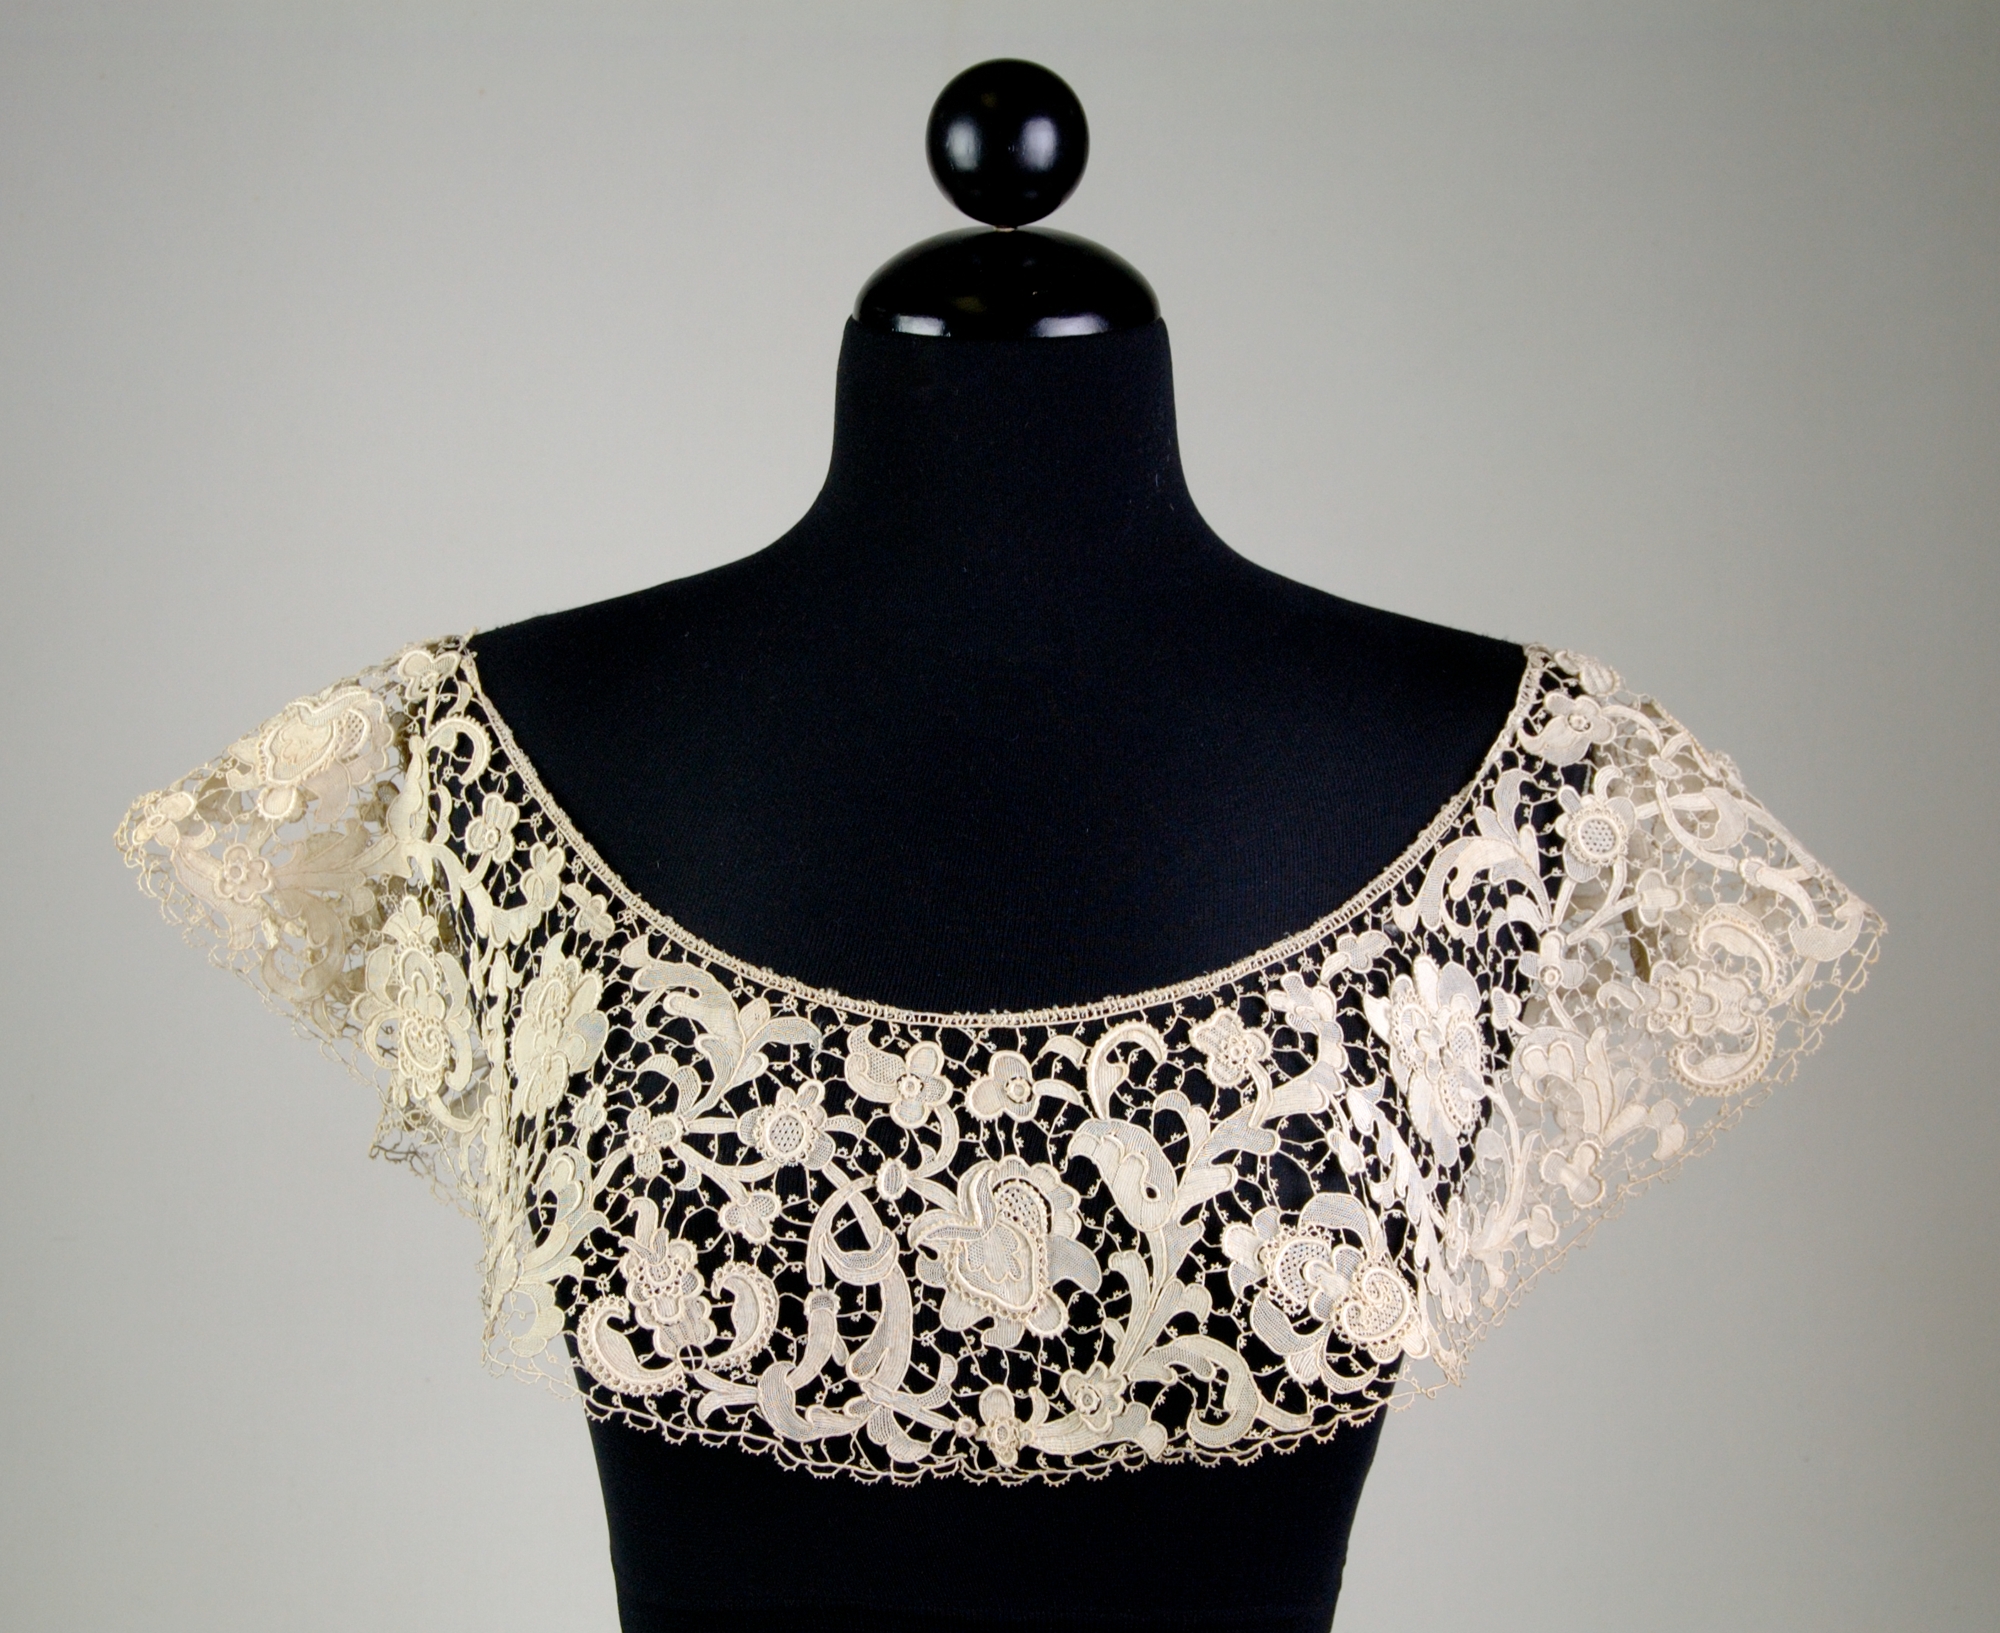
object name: bertha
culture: italian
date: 1890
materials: linen